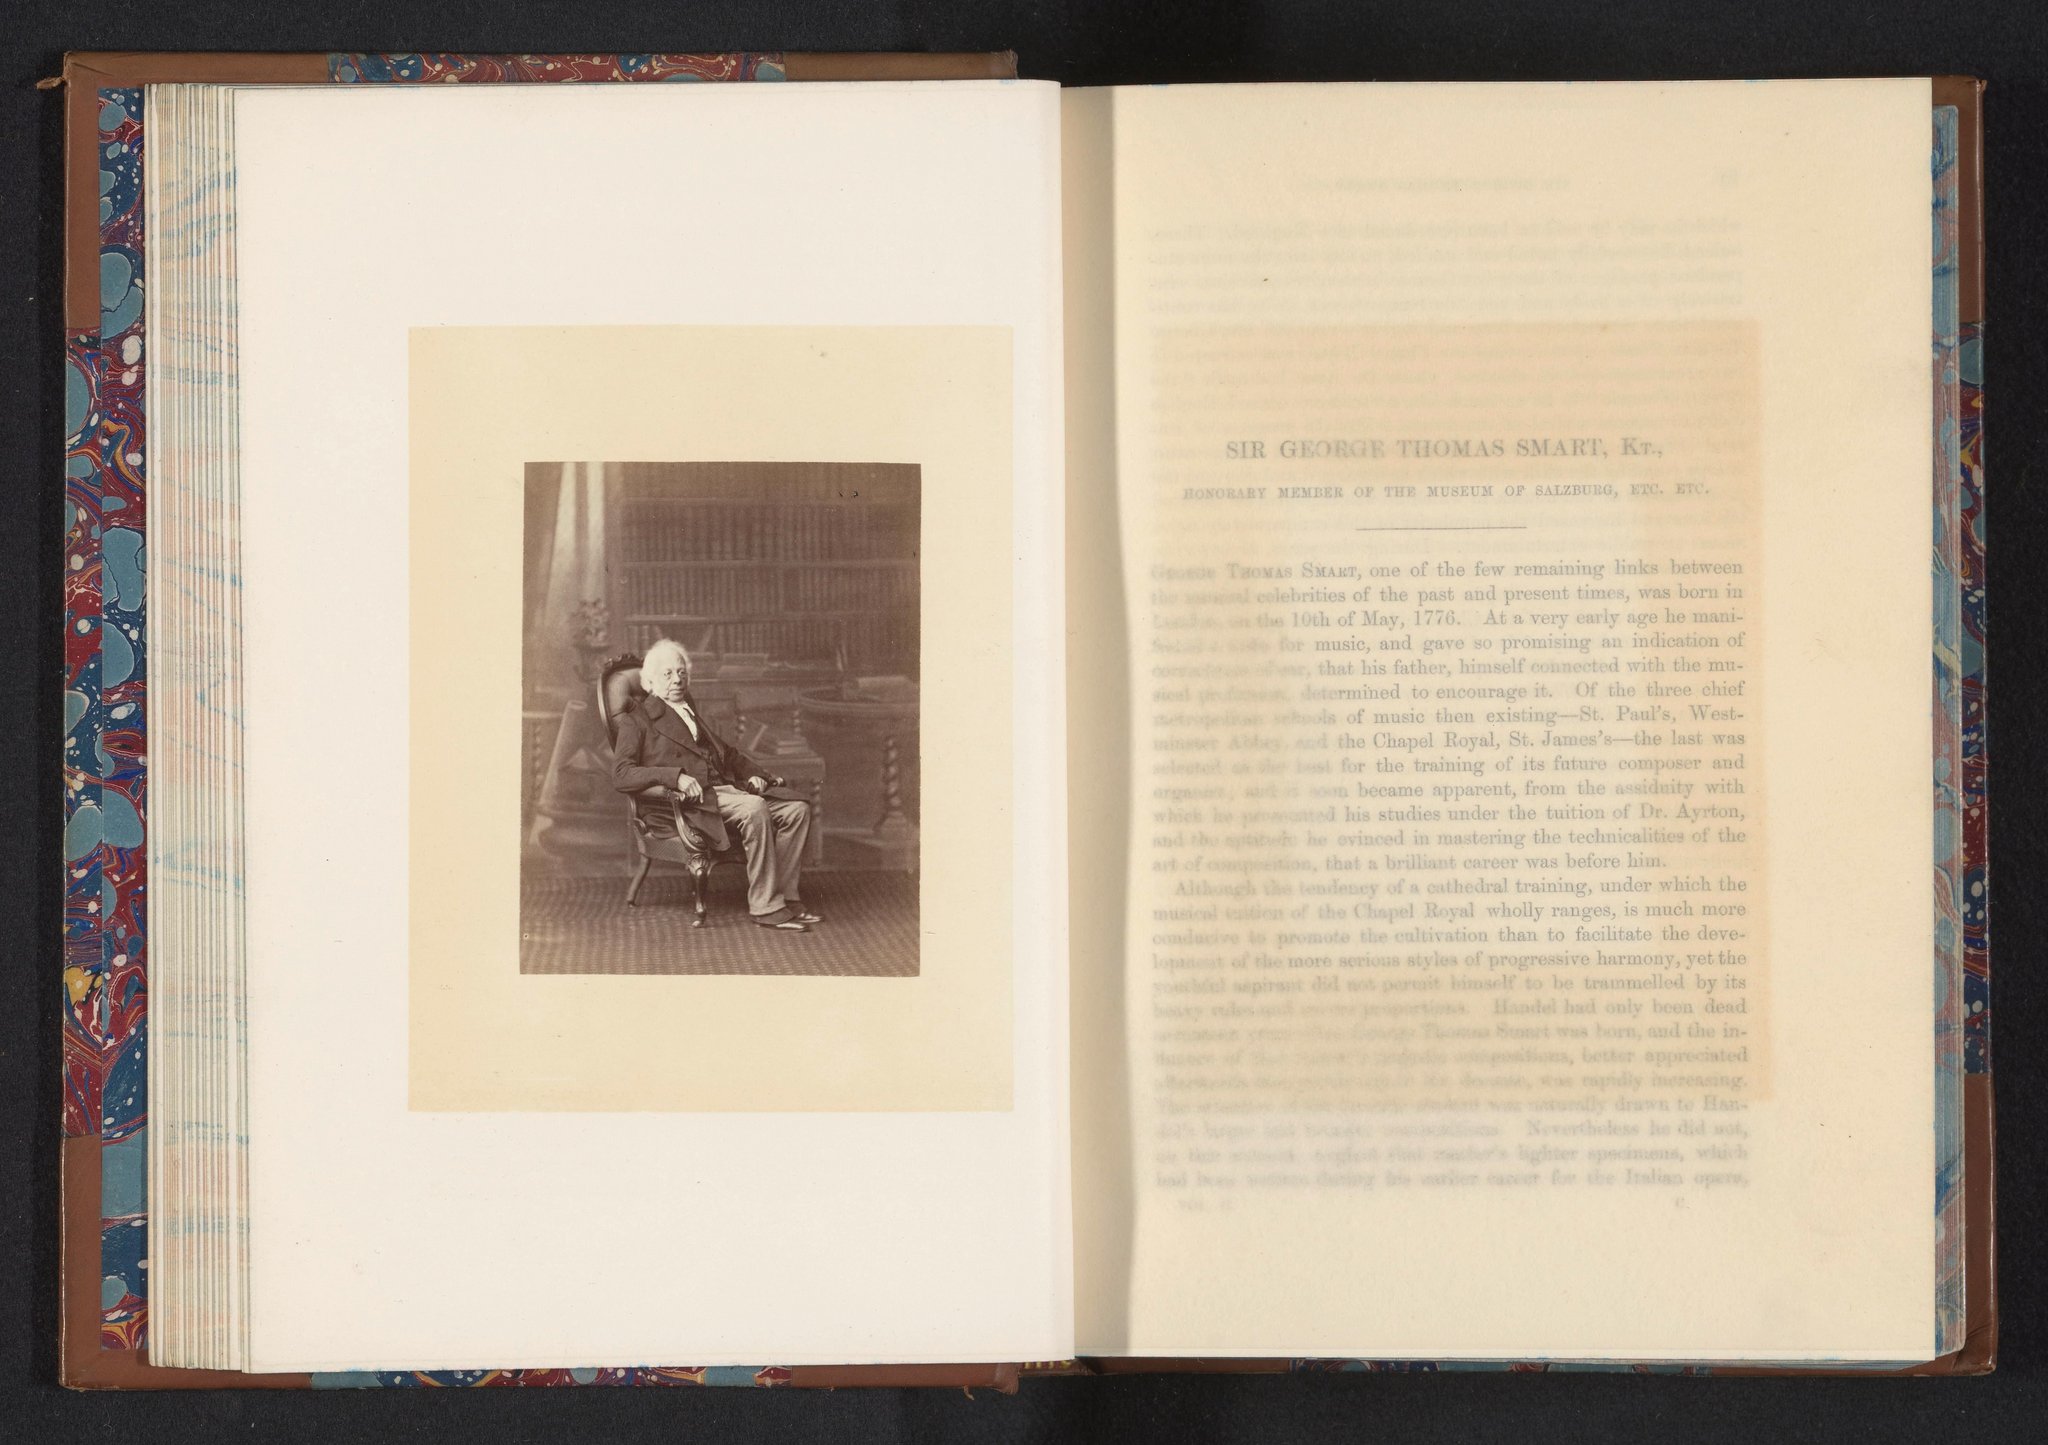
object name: photograph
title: Portret van George Thomas Smart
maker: ernest edwards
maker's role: fotograaf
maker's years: 1837-1903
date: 1853-1867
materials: photographic support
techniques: albumen print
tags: musician, portrait of a musician